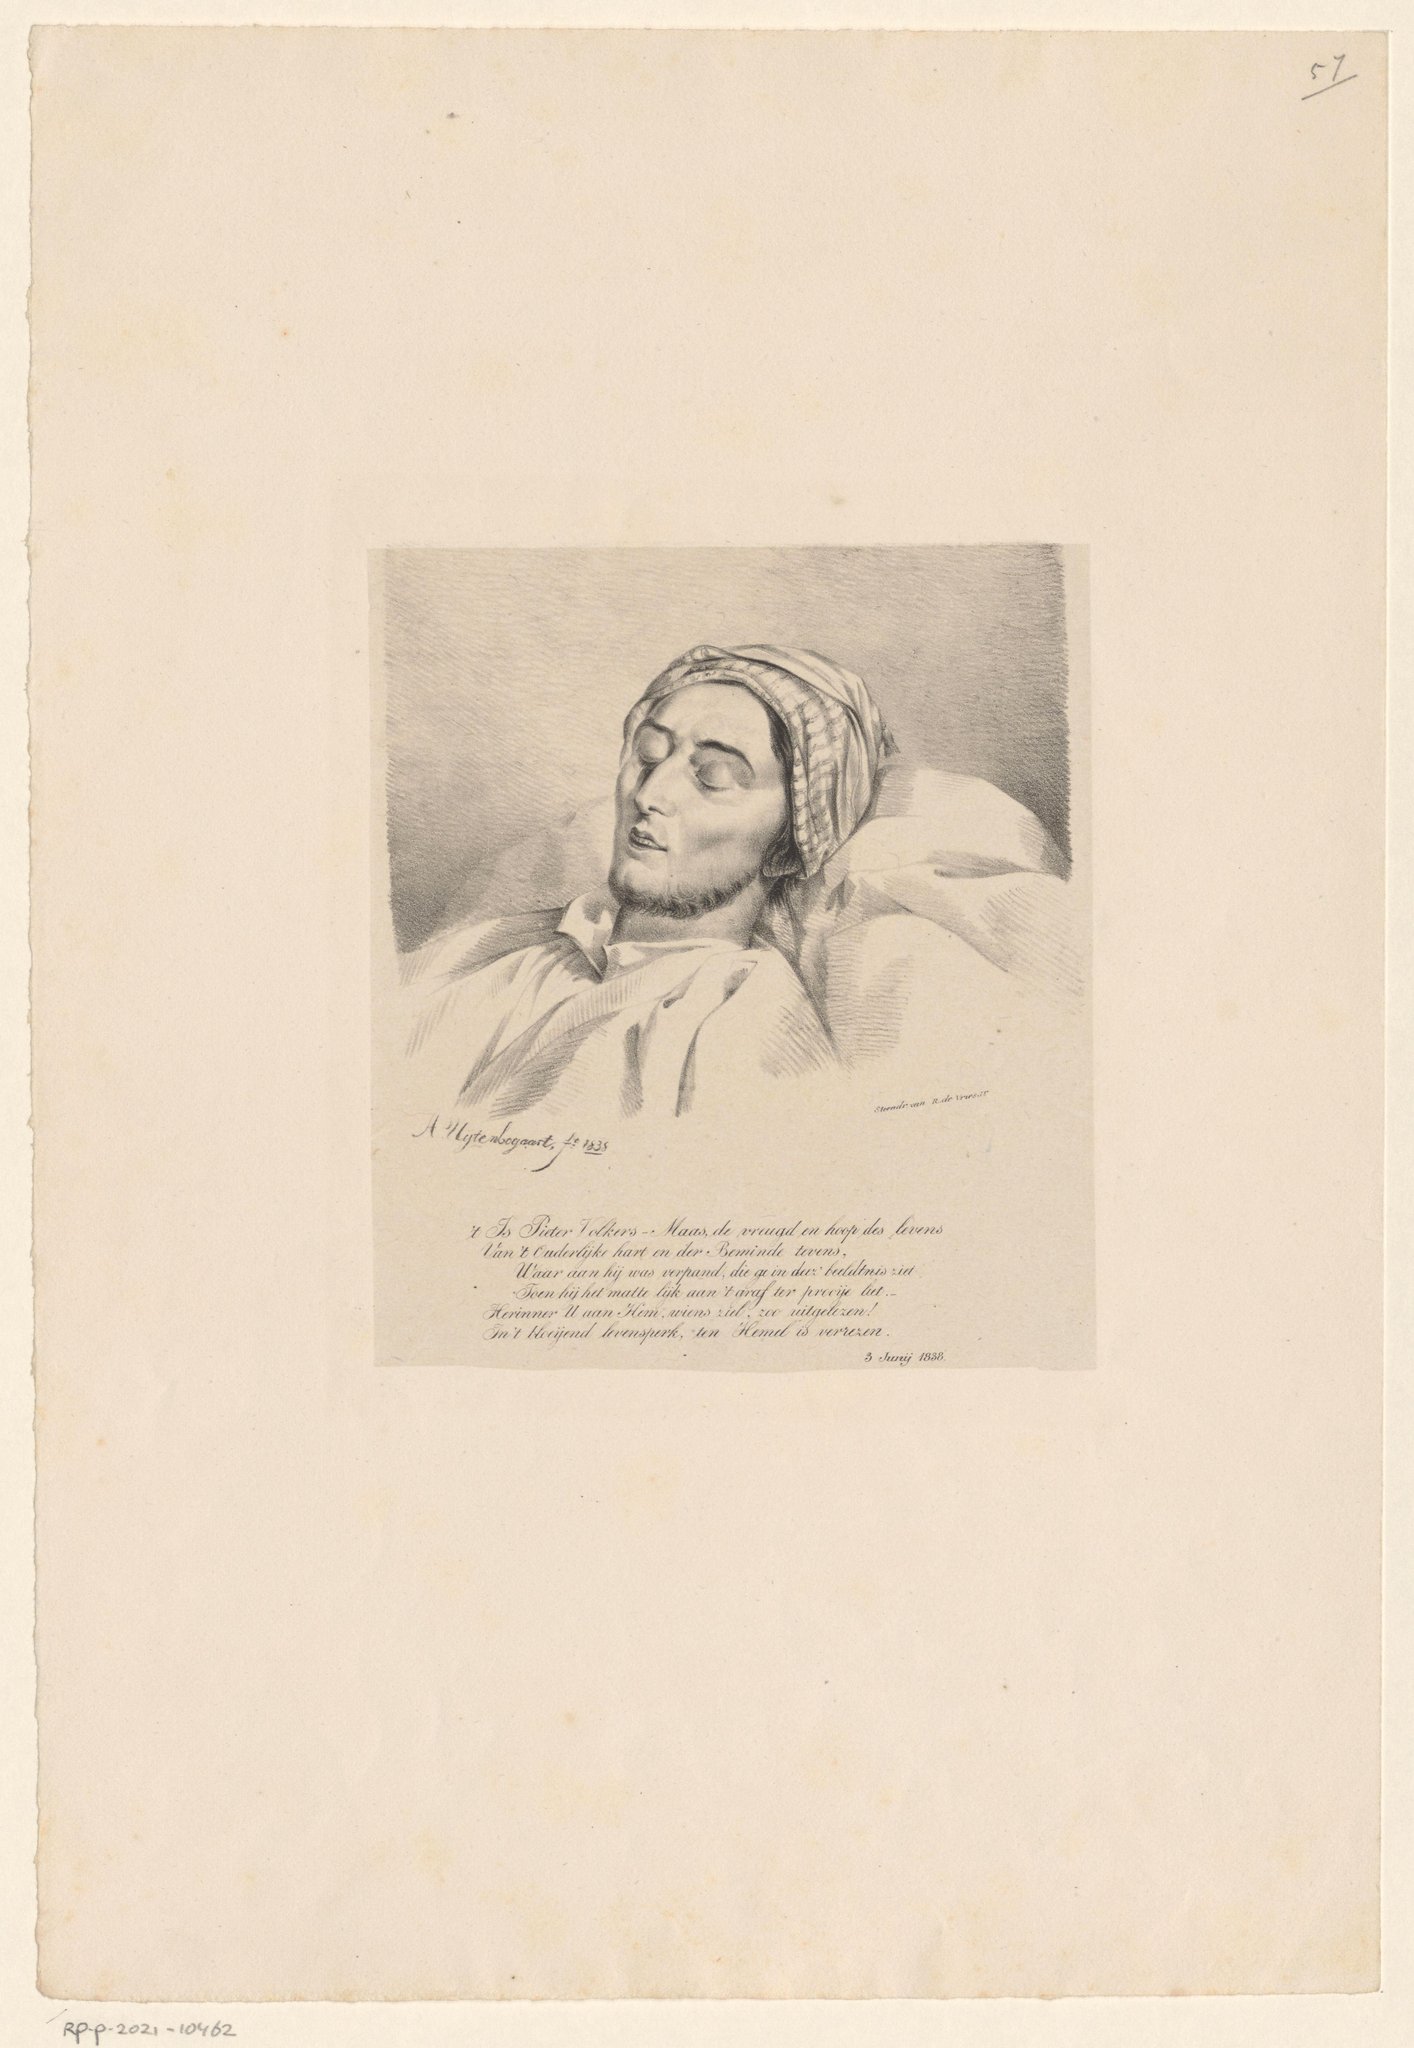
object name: print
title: Portret van Pieter Volkers-Maas op zijn doodsbed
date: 1838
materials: paper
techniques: lithograph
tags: adult man, deathbed, historical persons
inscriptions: collector's mark: Lugt 2228